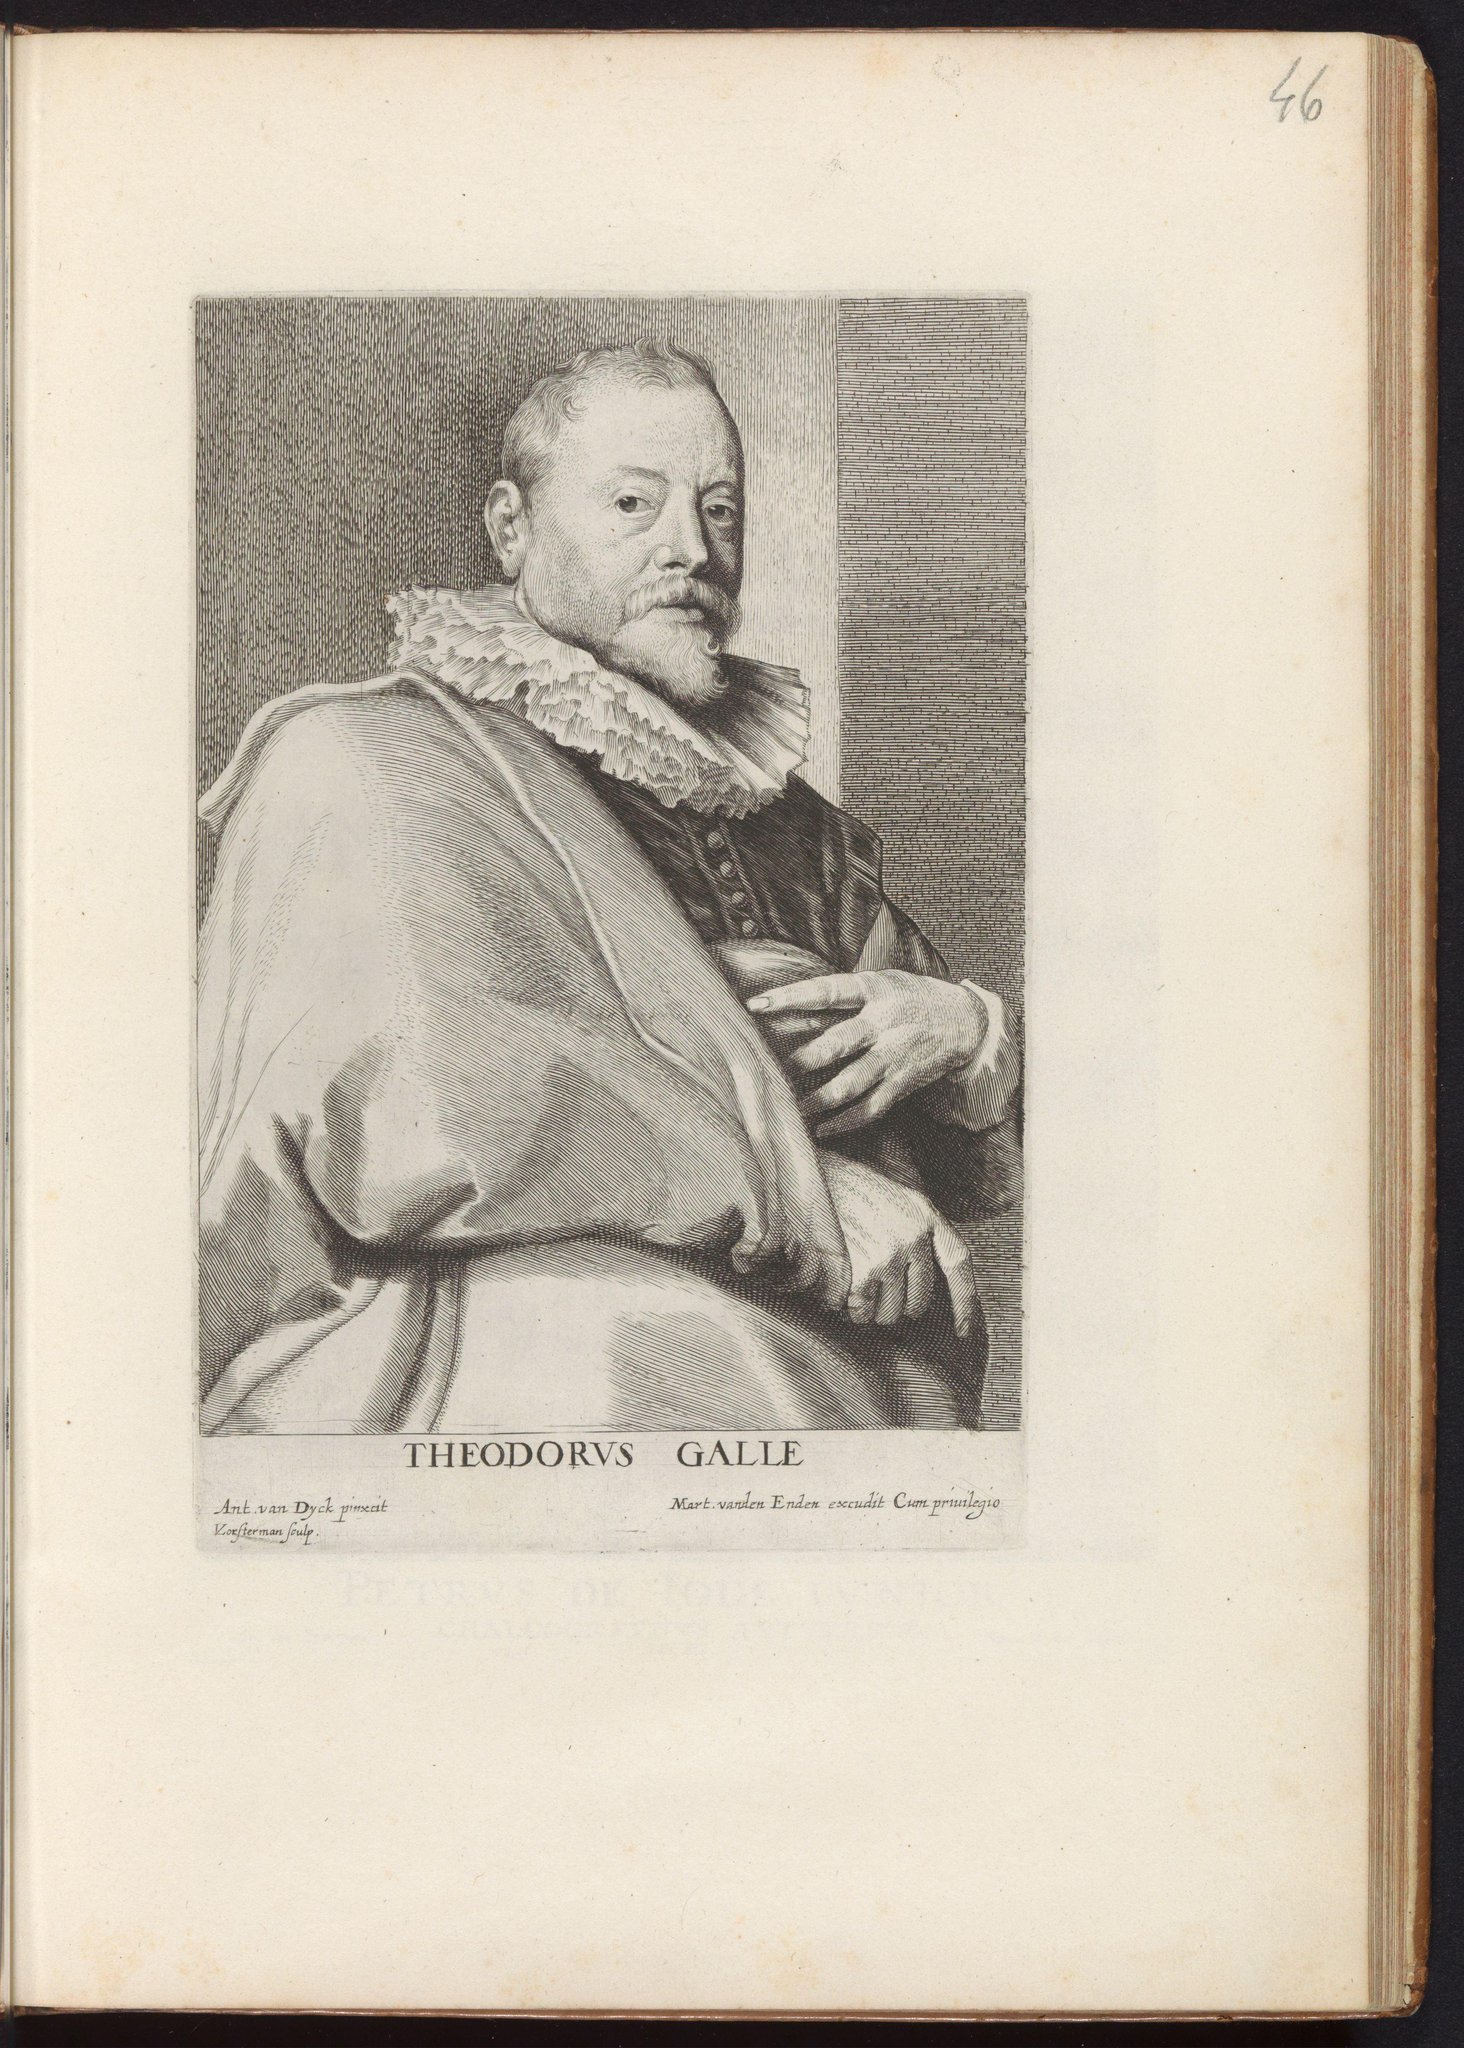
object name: album leaf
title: Icones Principum Vivorum Doctorum Pictorum Chalcographorum Statuariorum nec non Amatorum Pictoriae Artis Numero Centum ab Antonio van Dyck Pictore ad Vivum Expressae Eiusq: Sumptibus aeri incisae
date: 1630-1641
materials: paper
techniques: engraving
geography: antwerp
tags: antwerp, print maker, theodoor galle, portrait, self-portrait of graphic artist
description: Portret van de prentmaker en uitgever Theodoor Galle. Deze prent maakt deel uit van een album.